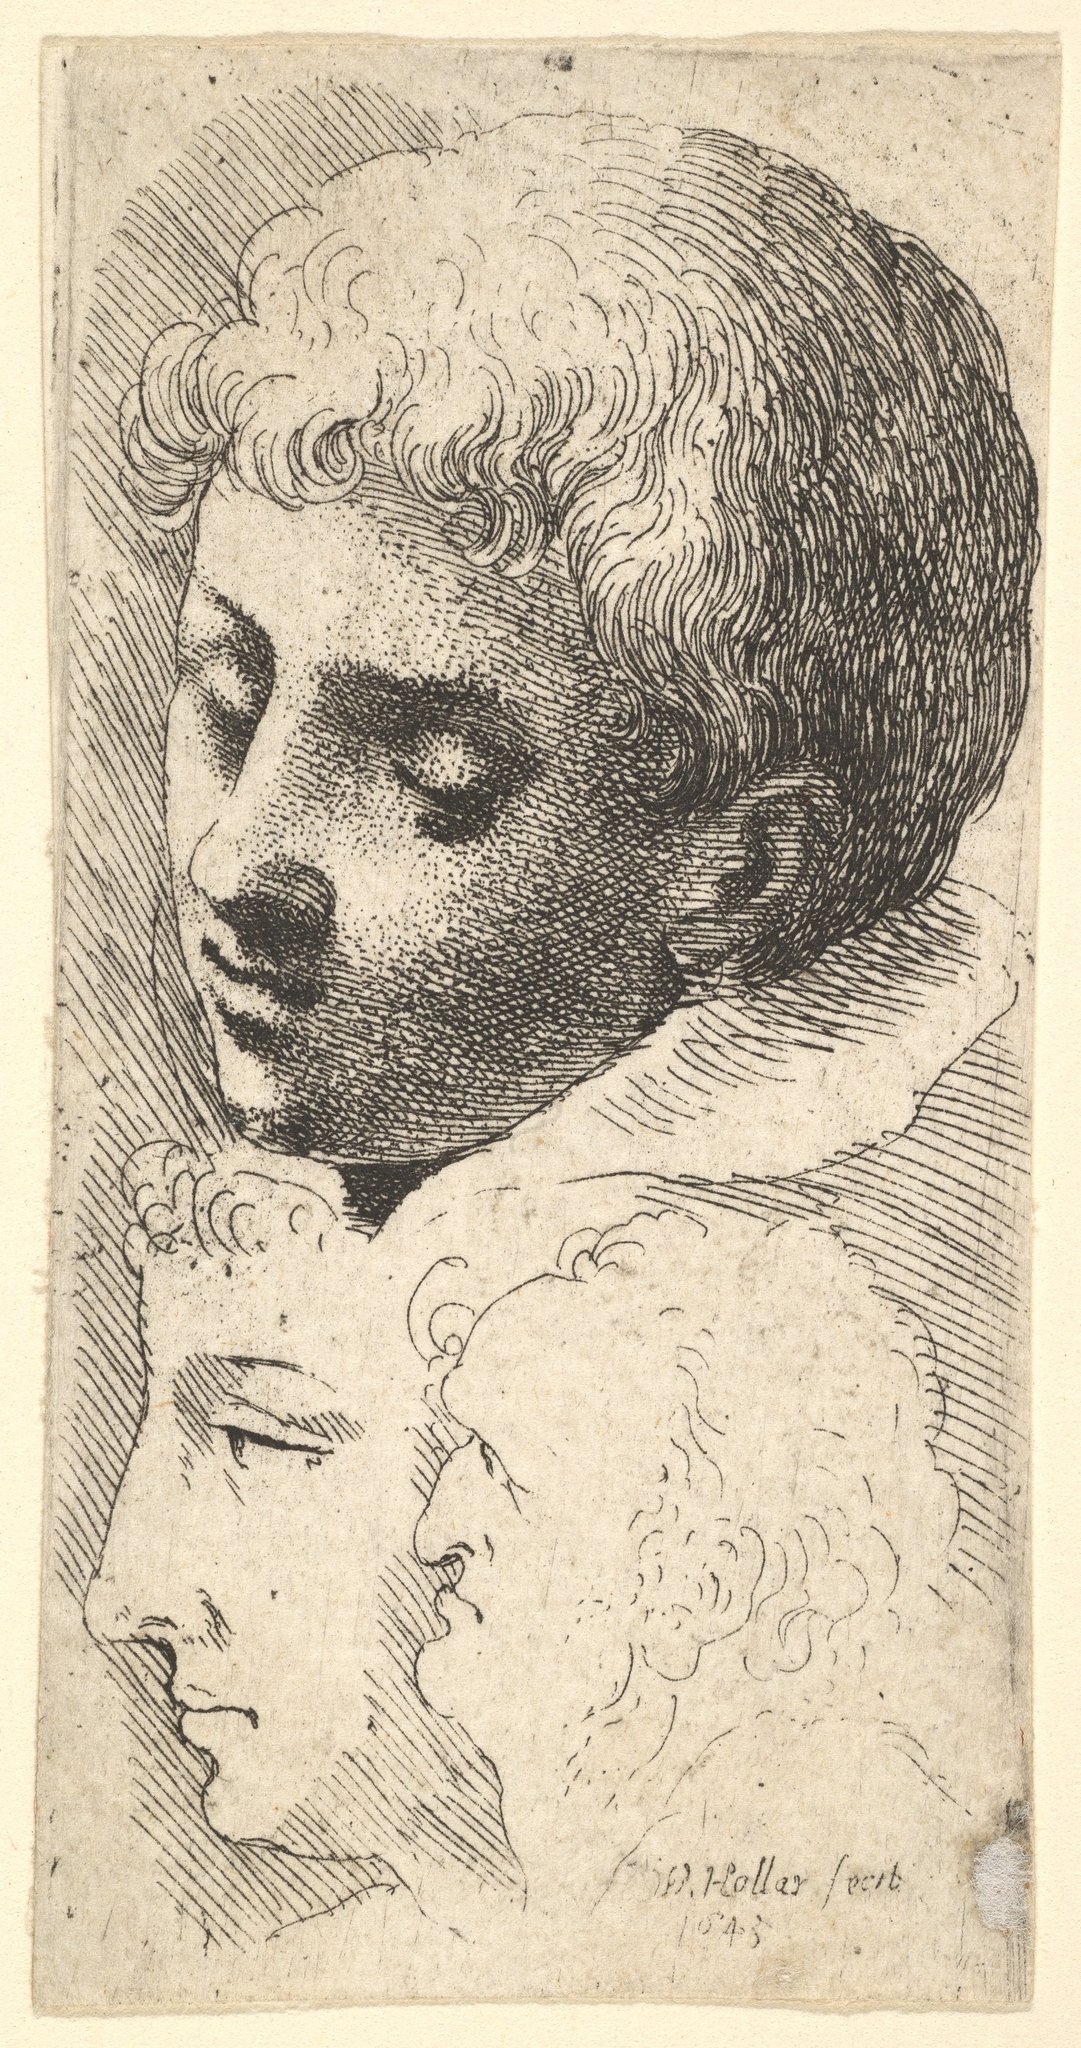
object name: print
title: Three heads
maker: wenceslaus hollar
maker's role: artist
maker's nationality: bohemian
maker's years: 1607-1677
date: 1645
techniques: etching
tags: heads,men